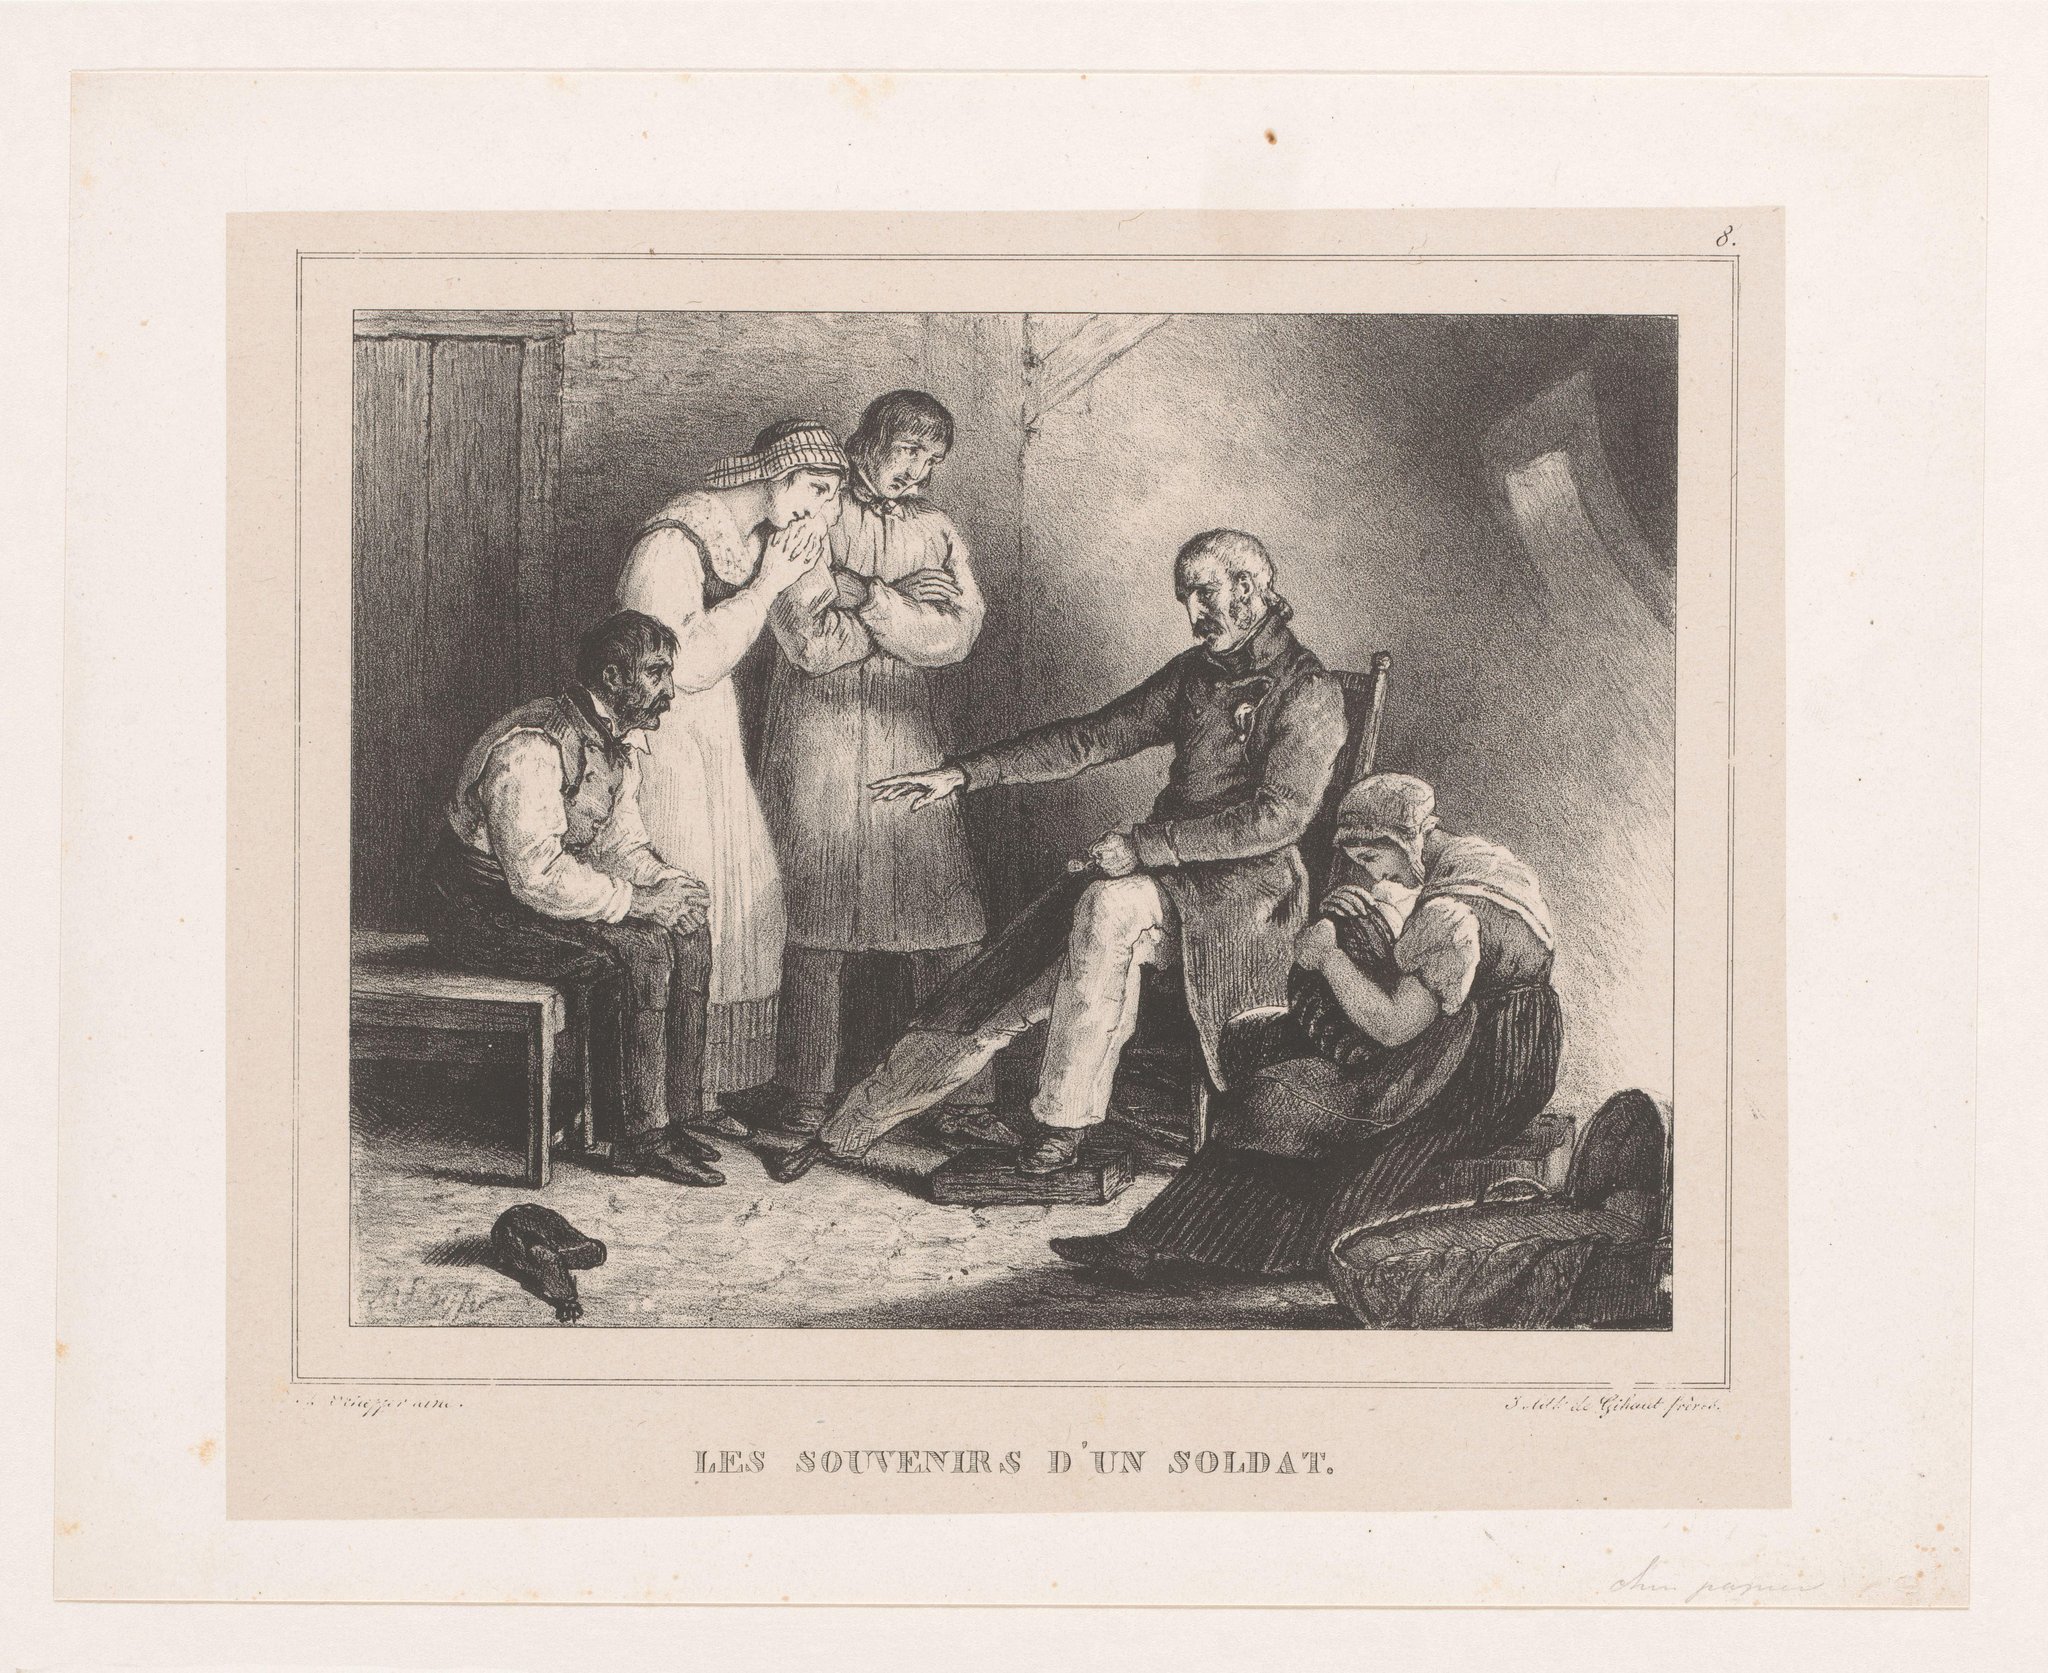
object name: print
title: Oude man met houten been omringd door vier figuren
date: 1829-1839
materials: paper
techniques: lithograph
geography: paris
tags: wooden leg, old man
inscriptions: collector's mark: Lugt 2228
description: Een oude man met houten been zit op een stoel. Naast hem zit een vrouw met kind op schoot. Voor hem op een bank zit een man naar wie hij wijst. Daarnaast staat een jonge vrouw leunend op de schouder van de jongeman naast haar. Zij luisteren naar de oude man.